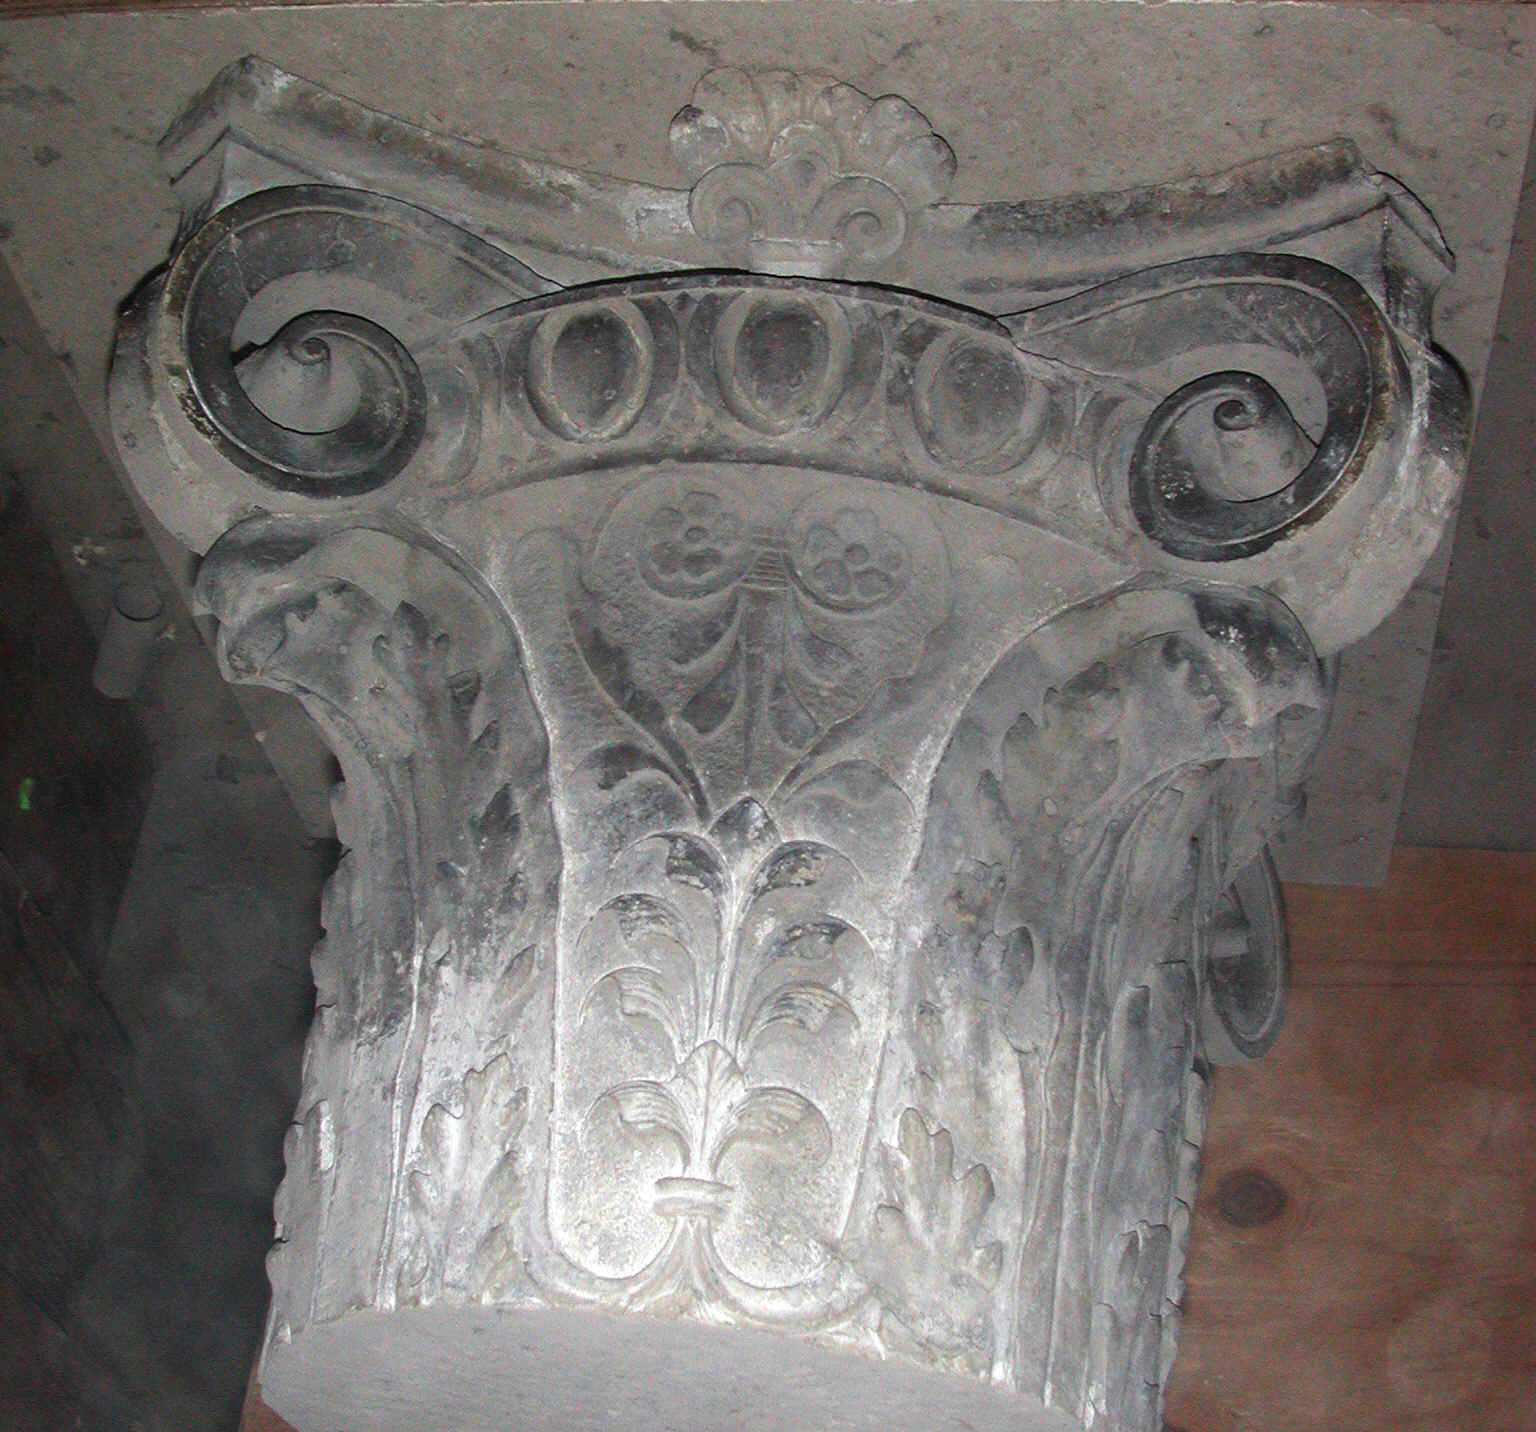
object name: capital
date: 1451-1500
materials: stone